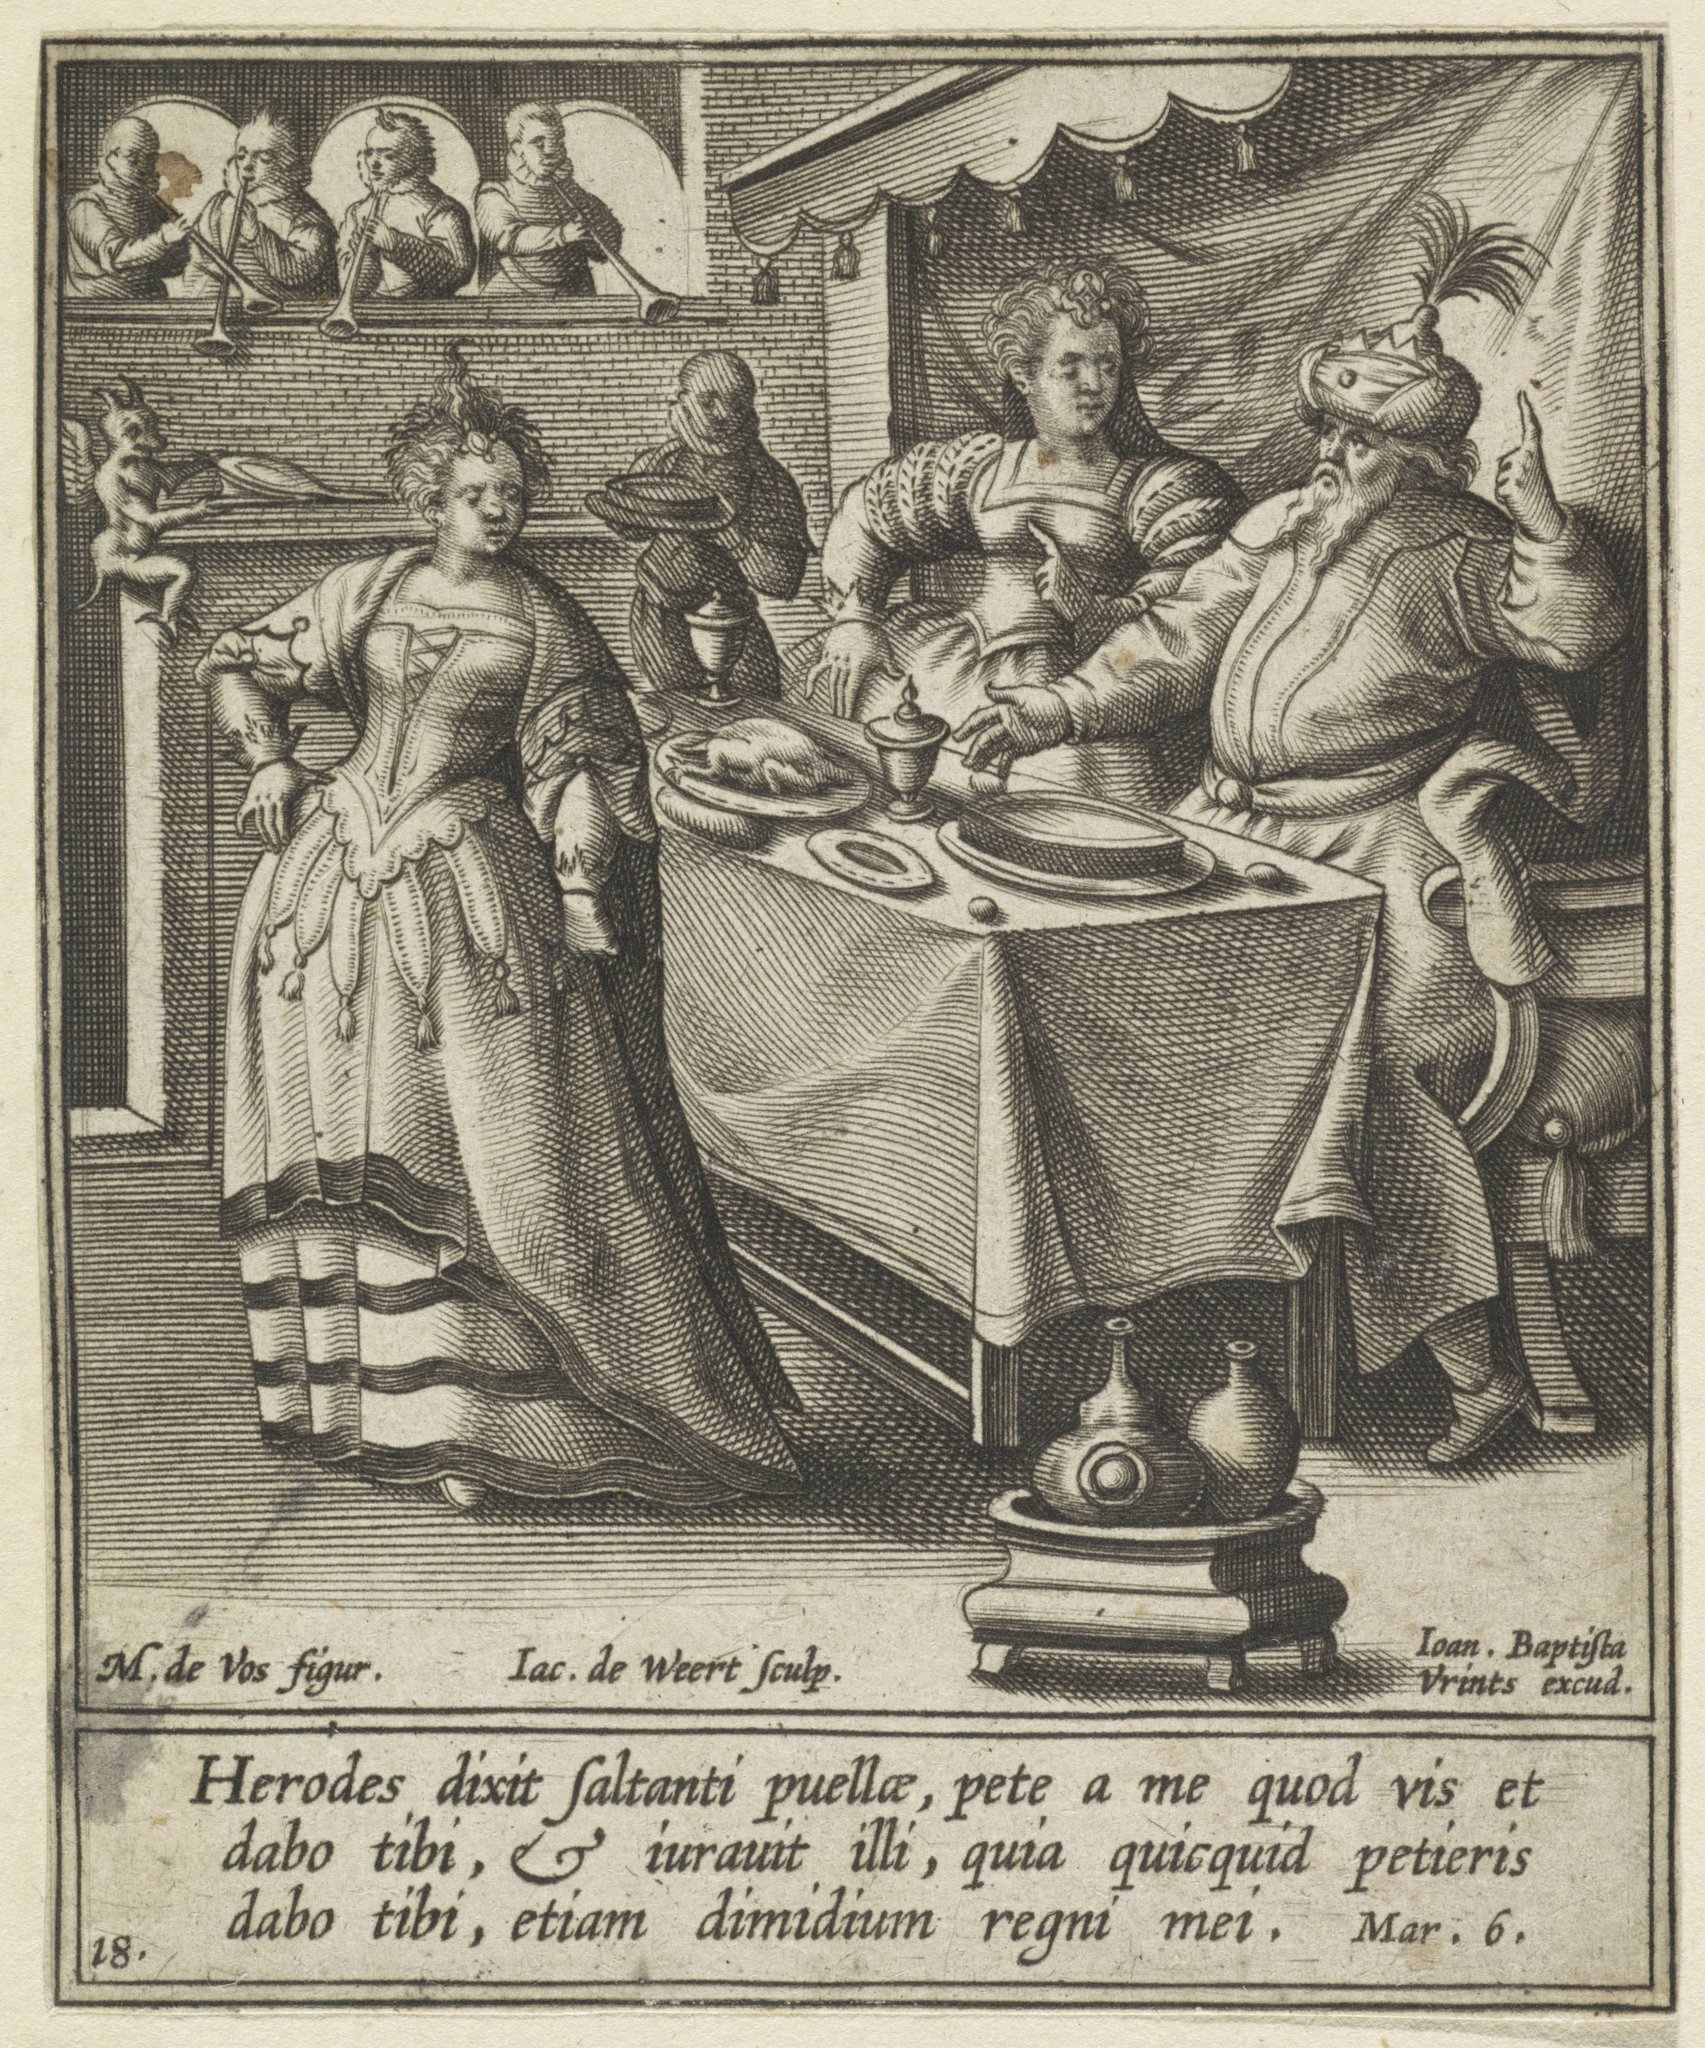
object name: print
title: Leven van Johannes de Doper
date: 1580-1600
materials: paper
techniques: engraving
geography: antwerp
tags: herod swearing to fulfill any wish of salome, horn, trumpet, cornet, trombone, tuba, bellows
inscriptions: collector's mark: Lugt 240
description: Herodes en Herodias staan achter een gedekte tafel onder een baldakijn. Salome staat aan de andere kant van de tafel. Bij haar hoofd zweeft een duiveltje met een blaasbalg. Achter hen staat een bediende voor een loggia met bazuinspelers. Onder de voorstelling bevindt zich een drieregelige, Latijnse tekst met de beschrijving van de scène uit Mar. 6.